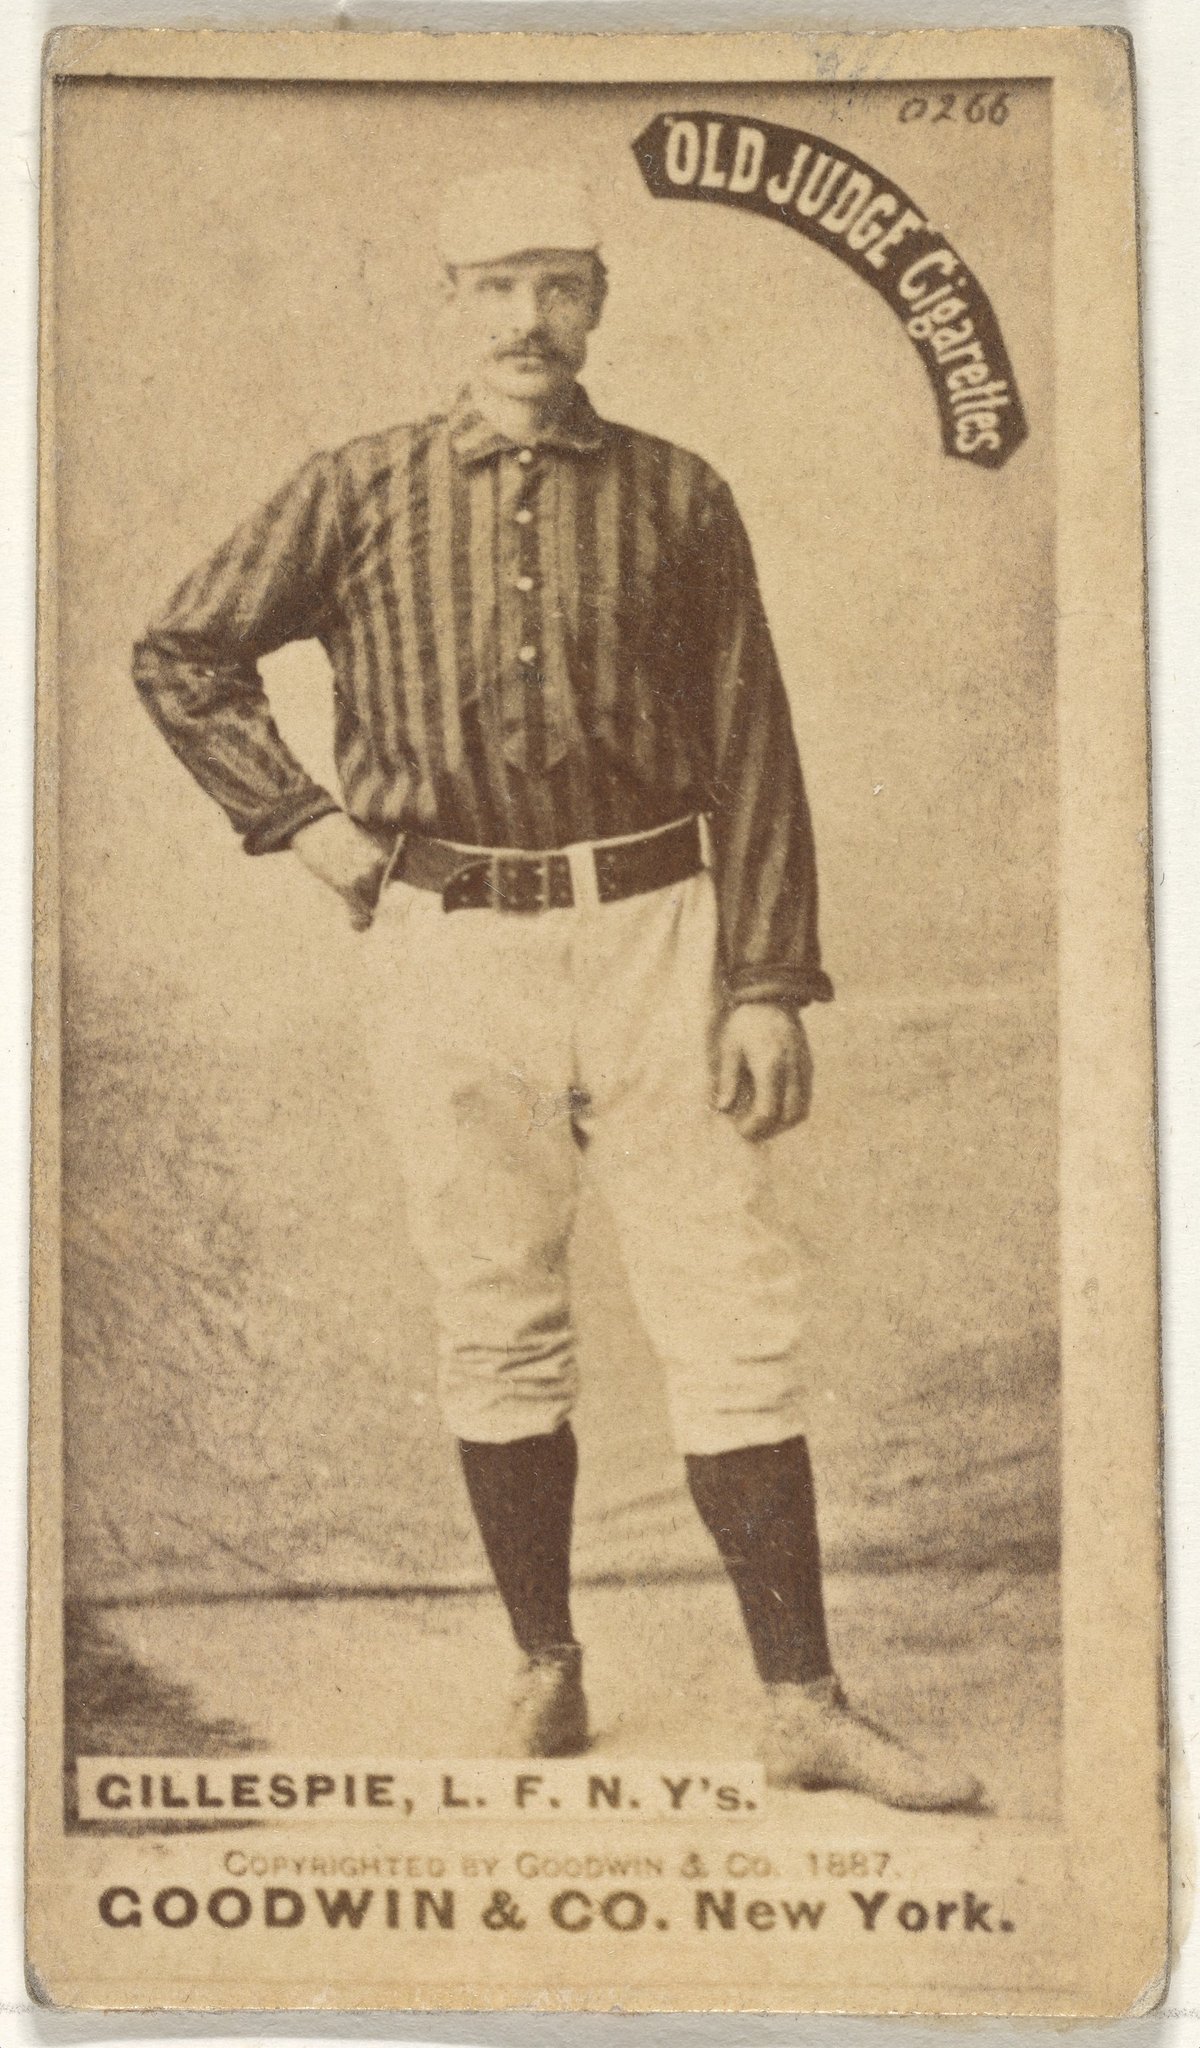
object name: baseball card, photograph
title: Peter Patrick Gillespie, Left Field, New York, from the Old Judge series (N172) for Old Judge Cigarettes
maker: goodwin & company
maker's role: publisher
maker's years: 1850-1950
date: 1887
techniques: albumen silver print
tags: men,portraits,baseball,athletes